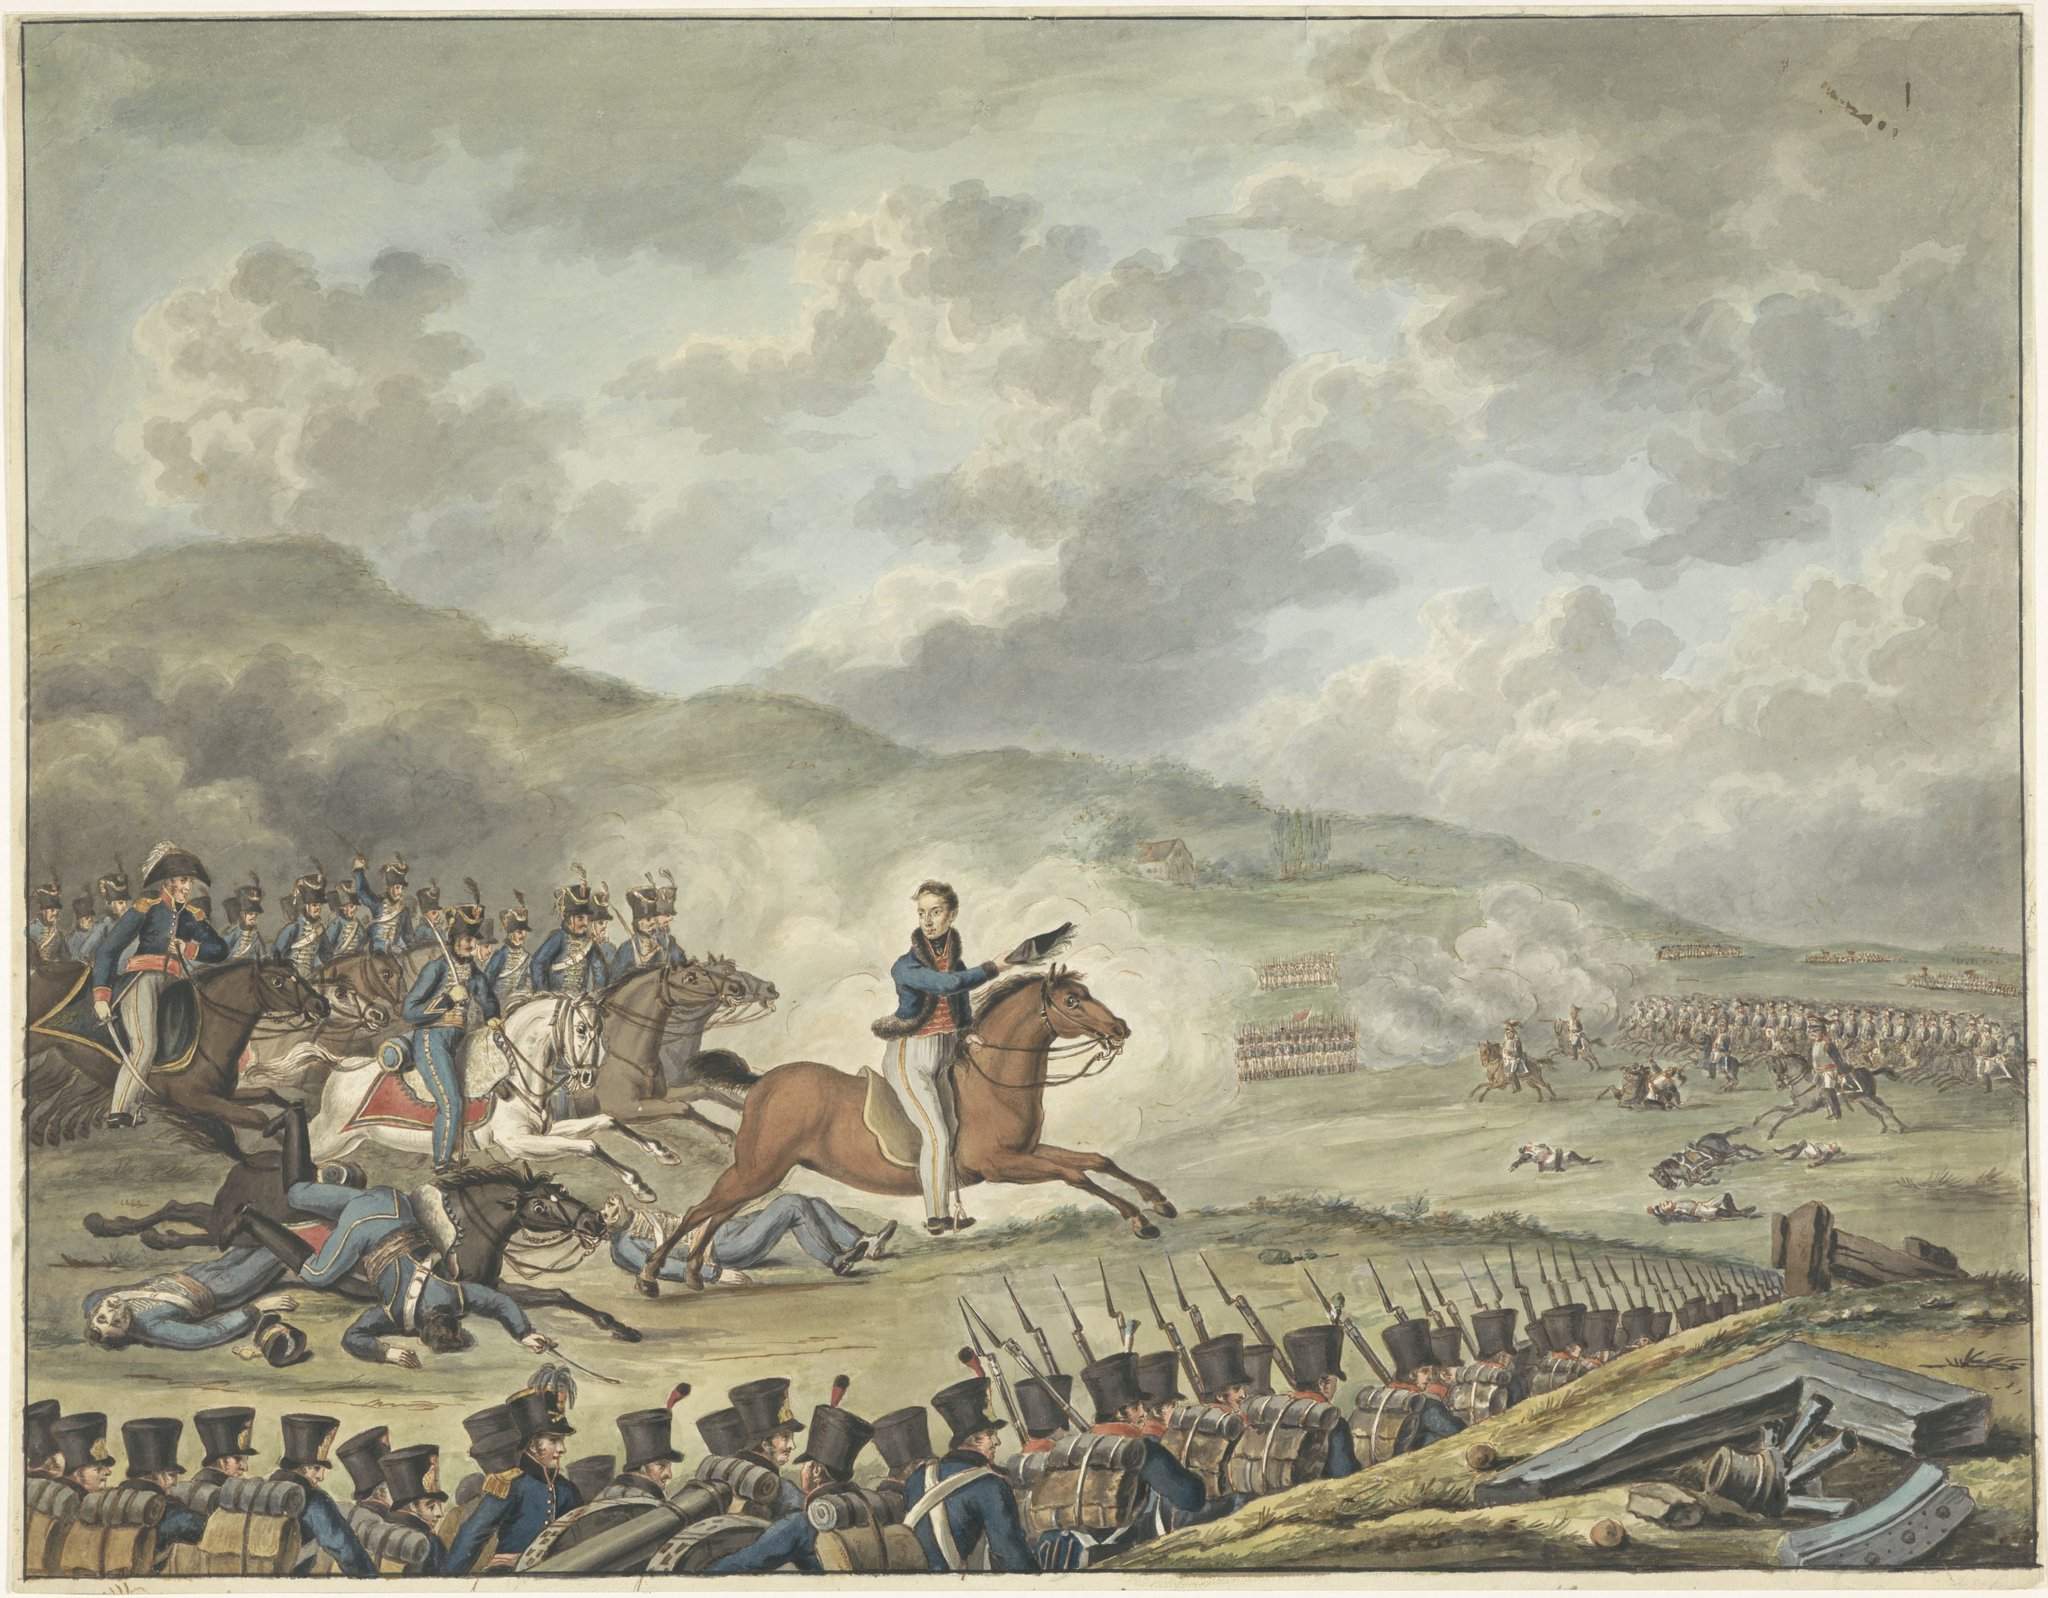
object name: drawing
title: Prins van Oranje leidt de Nederlandse troepen bij Quatre-Bras, 1815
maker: Anonymous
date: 1815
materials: paper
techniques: brush, pen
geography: netherlands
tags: william ii of the netherlands, battle (+ land forces)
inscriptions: collector's mark: Lugt 2228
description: Willem Frederik George, prins van Oranje, leidt de Nederlandse troepen tegen een Franse aanval tijdens de slag bij Quatre-Bras, 16 juni 1815. Centraal de prins van Oranje te paard, achter hem Brunswijkse huzaren, op de voorgrond rukt de infanterie op. Rechts de aanstormende Fransen.